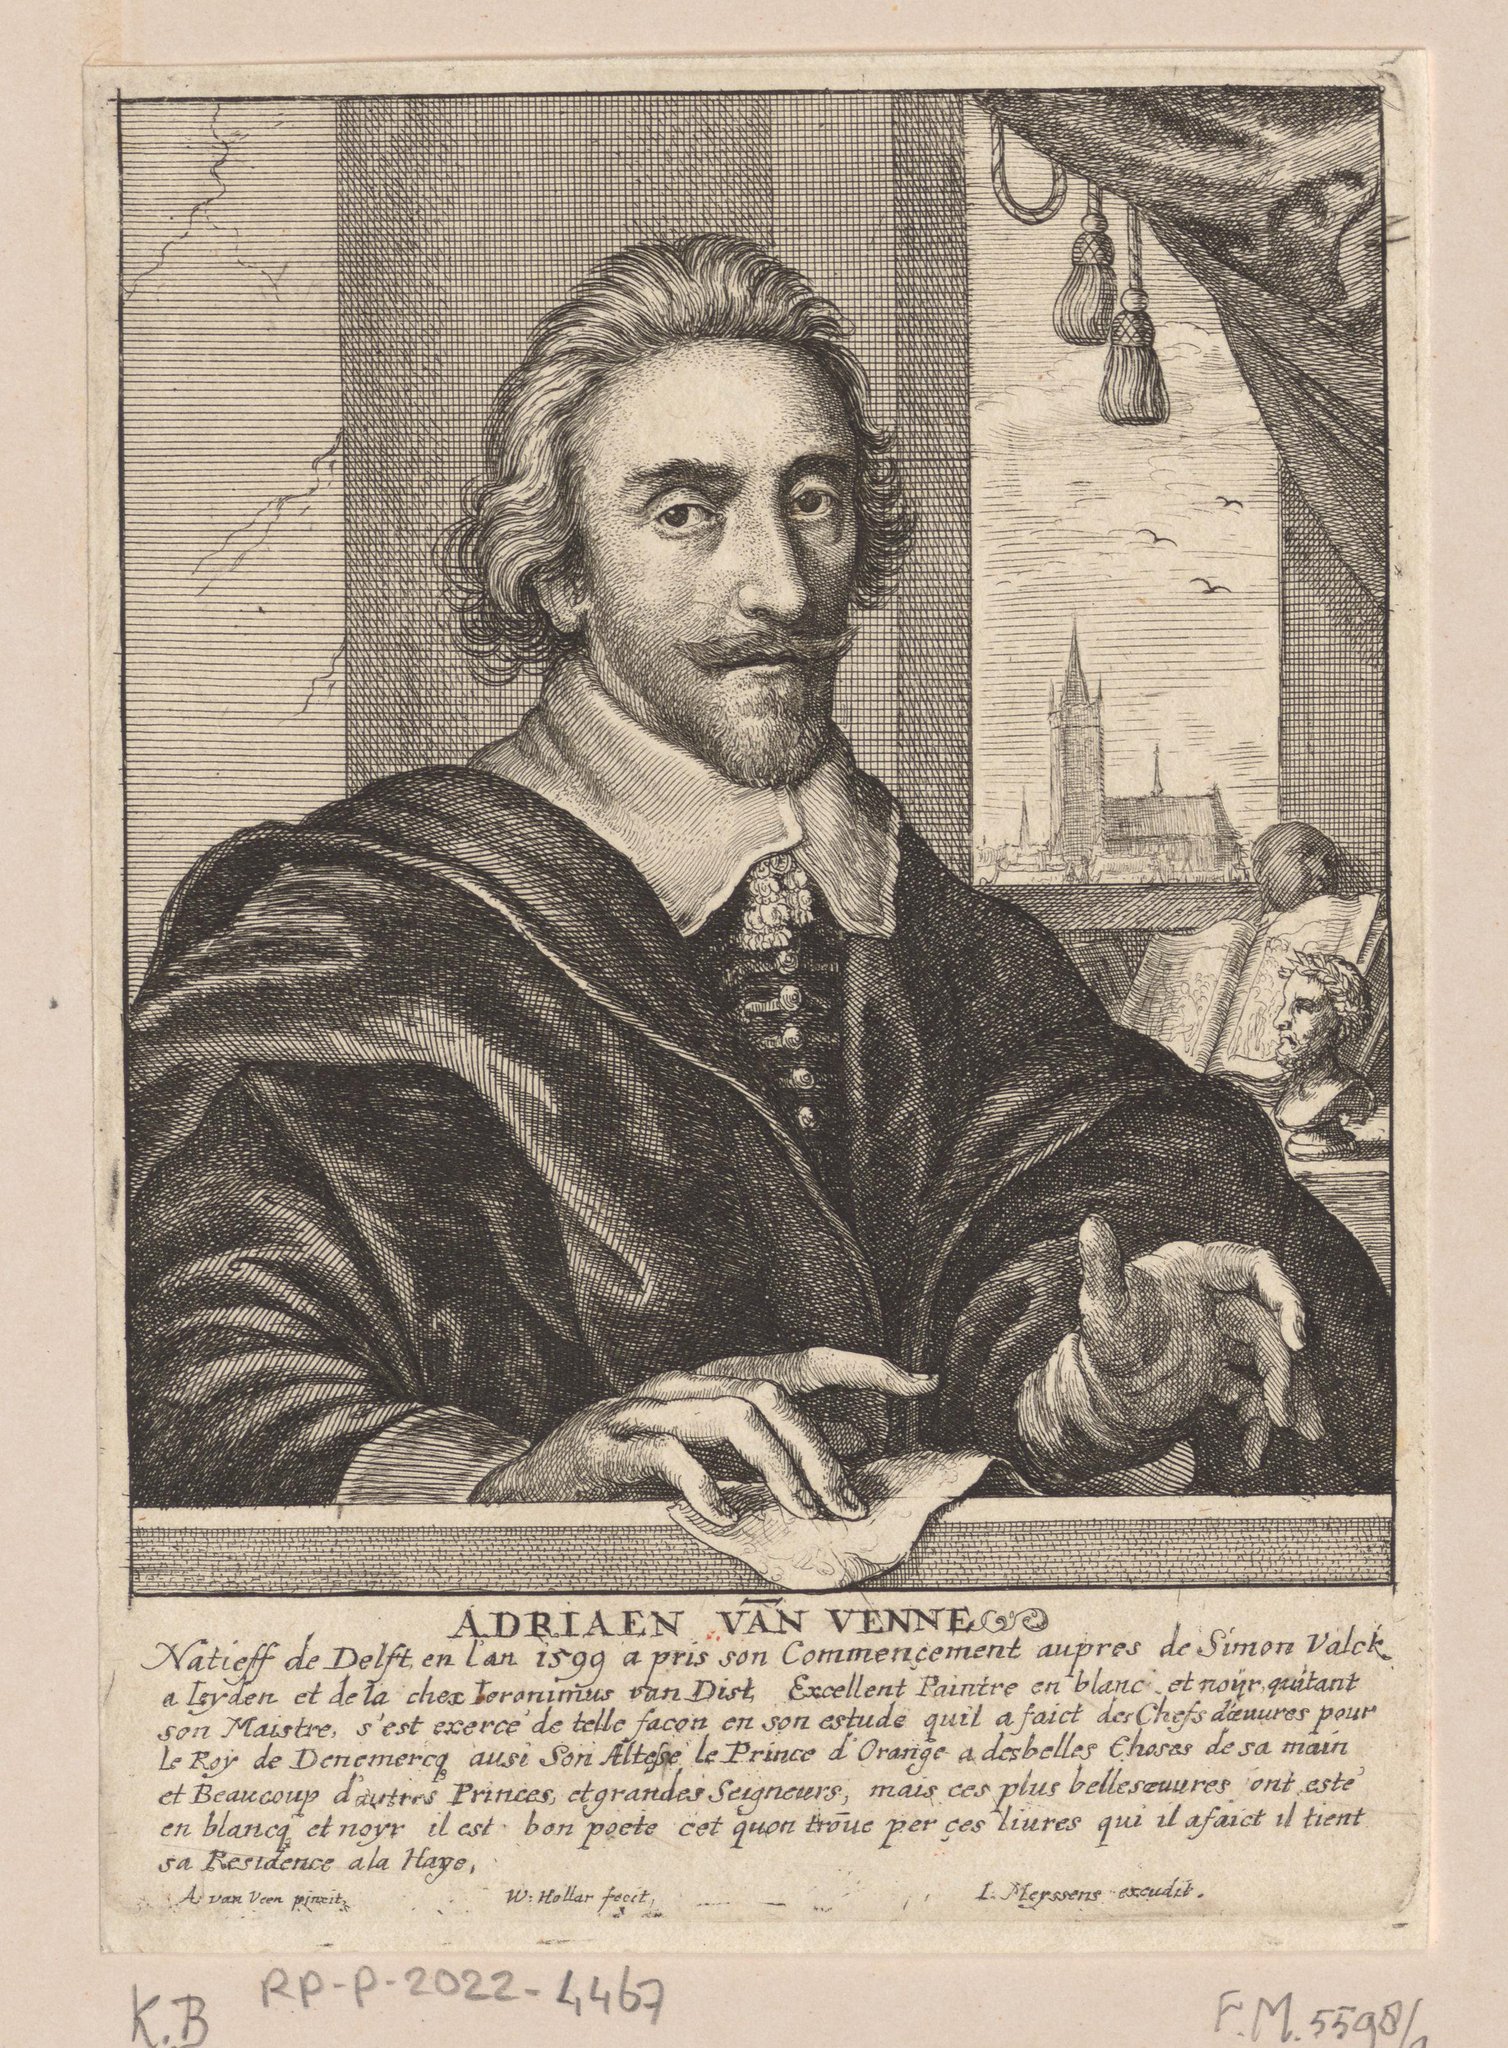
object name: print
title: Image de divers hommes desprit sublime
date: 1649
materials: paper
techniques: etching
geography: antwerp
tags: delft, the hague, painter, print maker, draughtsman, adriaen pietersz van de venne, drawing, sketch, historical persons, church (exterior), book - mm - book open, portrait, self-portrait of painter, writer, poet, author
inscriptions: collector's mark: Lugt 240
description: De prent uitgegeven als deel van de serie "Image de divers hommes desprit sublime", 1649. Prent met tekst op verso gebruikt in: Bie, Cornelis de. Het gulden Cabinet vande edel vry schilder const (...). Antwerpen: Jan Meyssens, 1661.